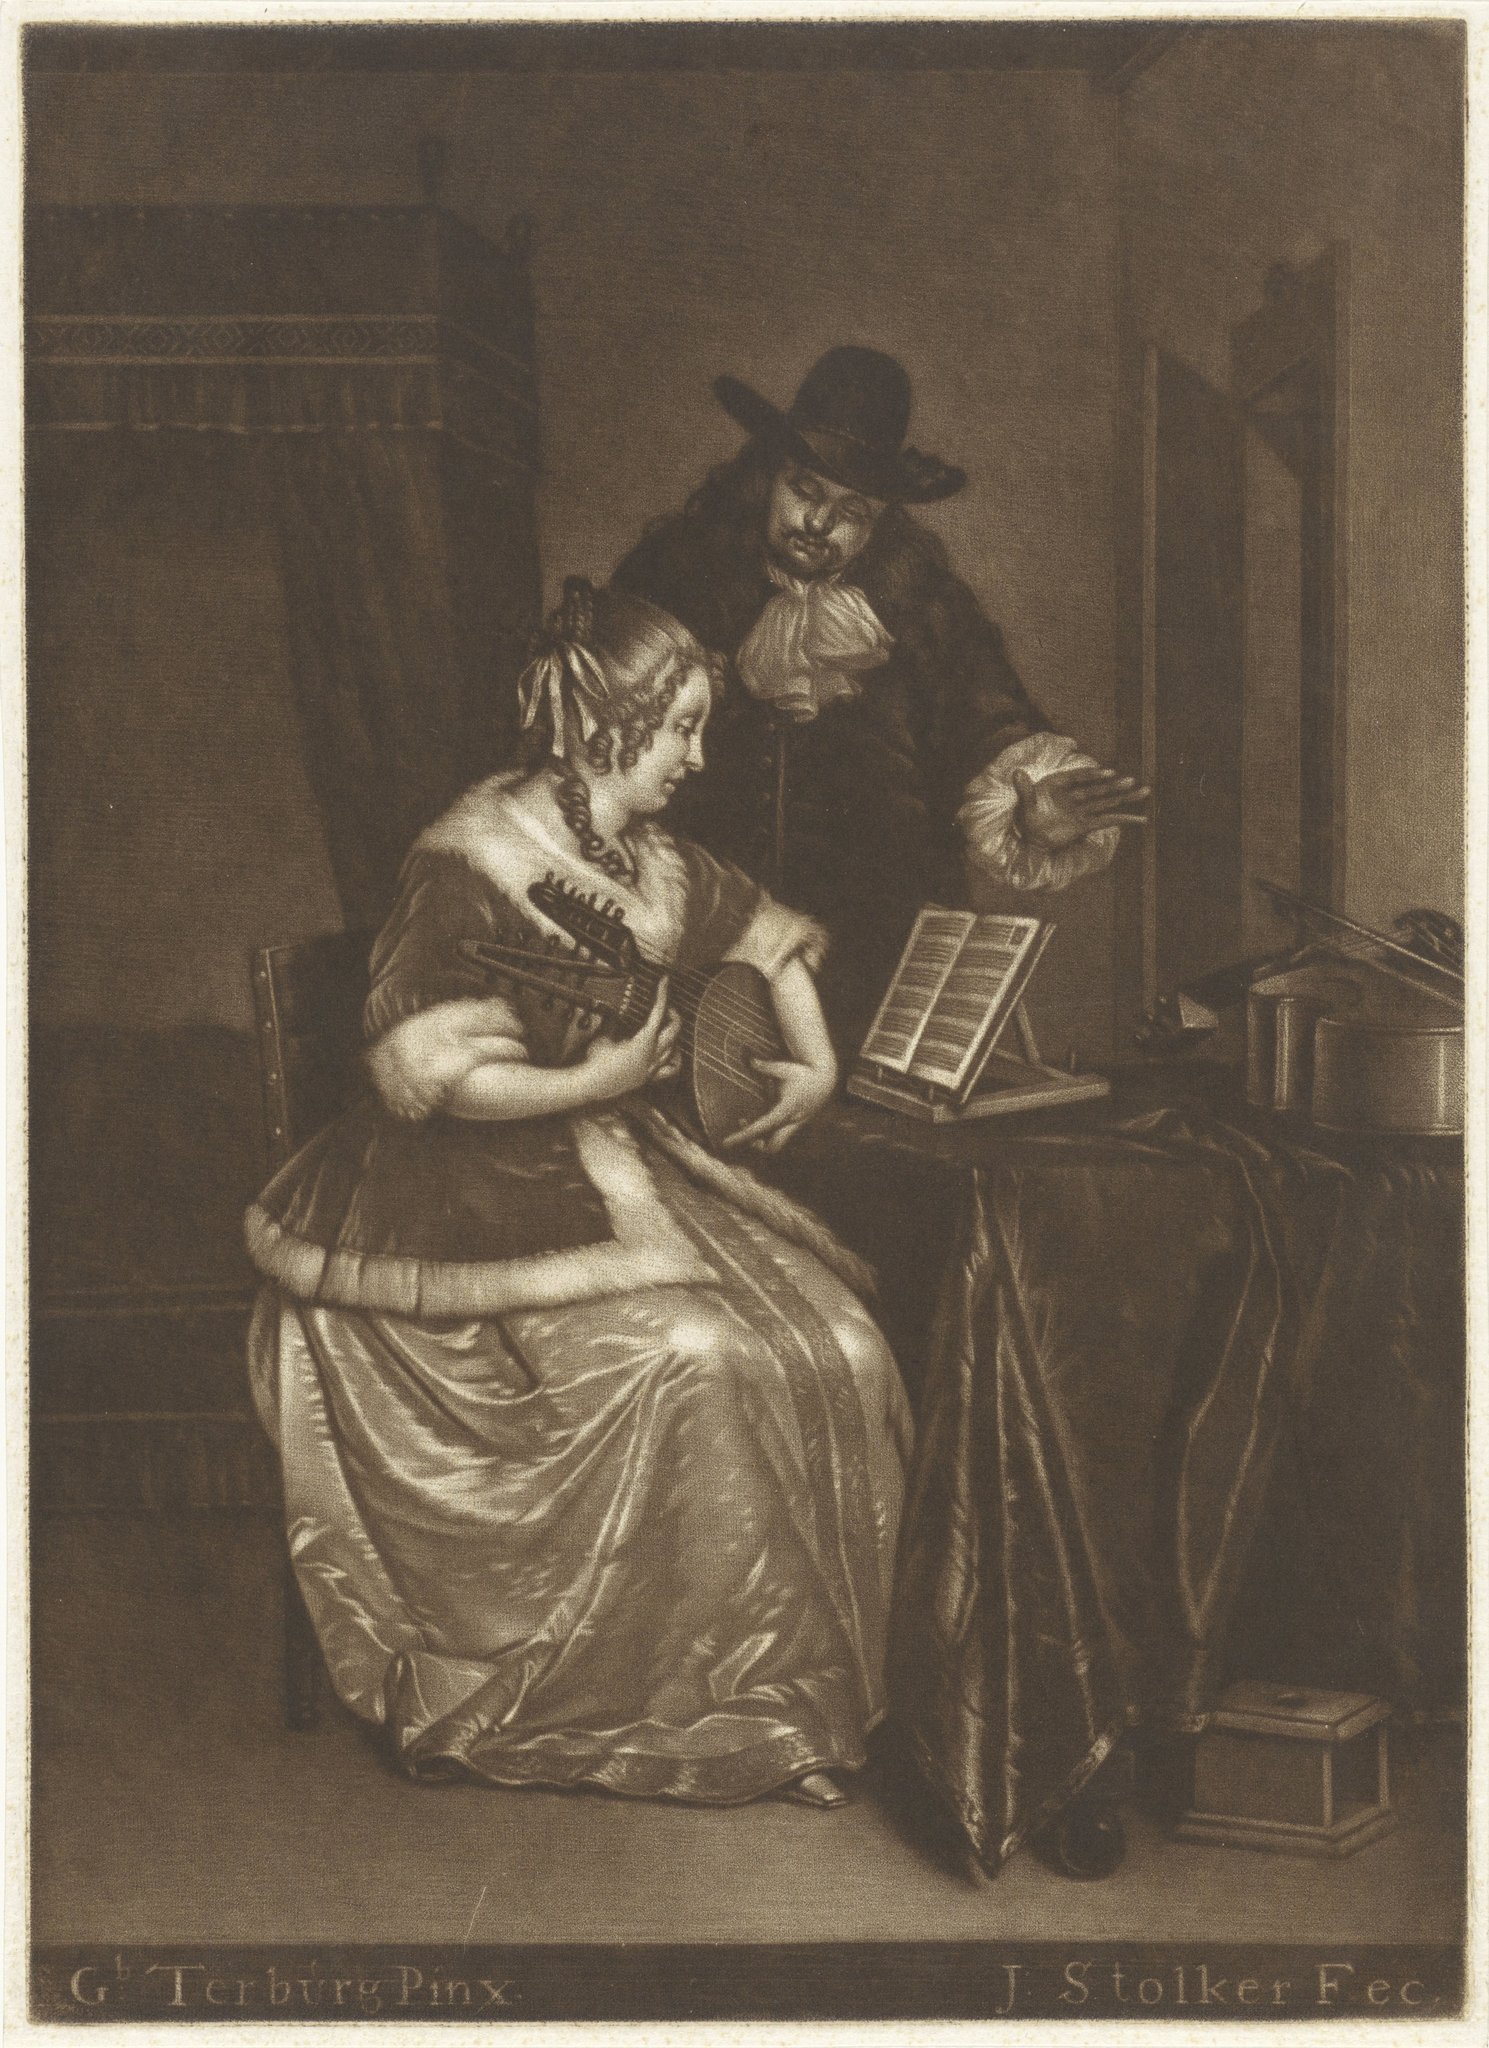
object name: print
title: Muziekles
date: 1734-1785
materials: paper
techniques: mezzotint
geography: northern netherlands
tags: musician training pupils, music-lesson, grand piano, head-gear: hat (+ men's clothes), lute, and special forms of lute, e.g.: theorbo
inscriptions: collector's mark: Lugt 2228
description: Een jonge vrouw speelt theorbe terwijl een man met een hoed de maat aangeeft. Op de muziekstandaard van de piano waaraan zij zit staat bladmuziek.